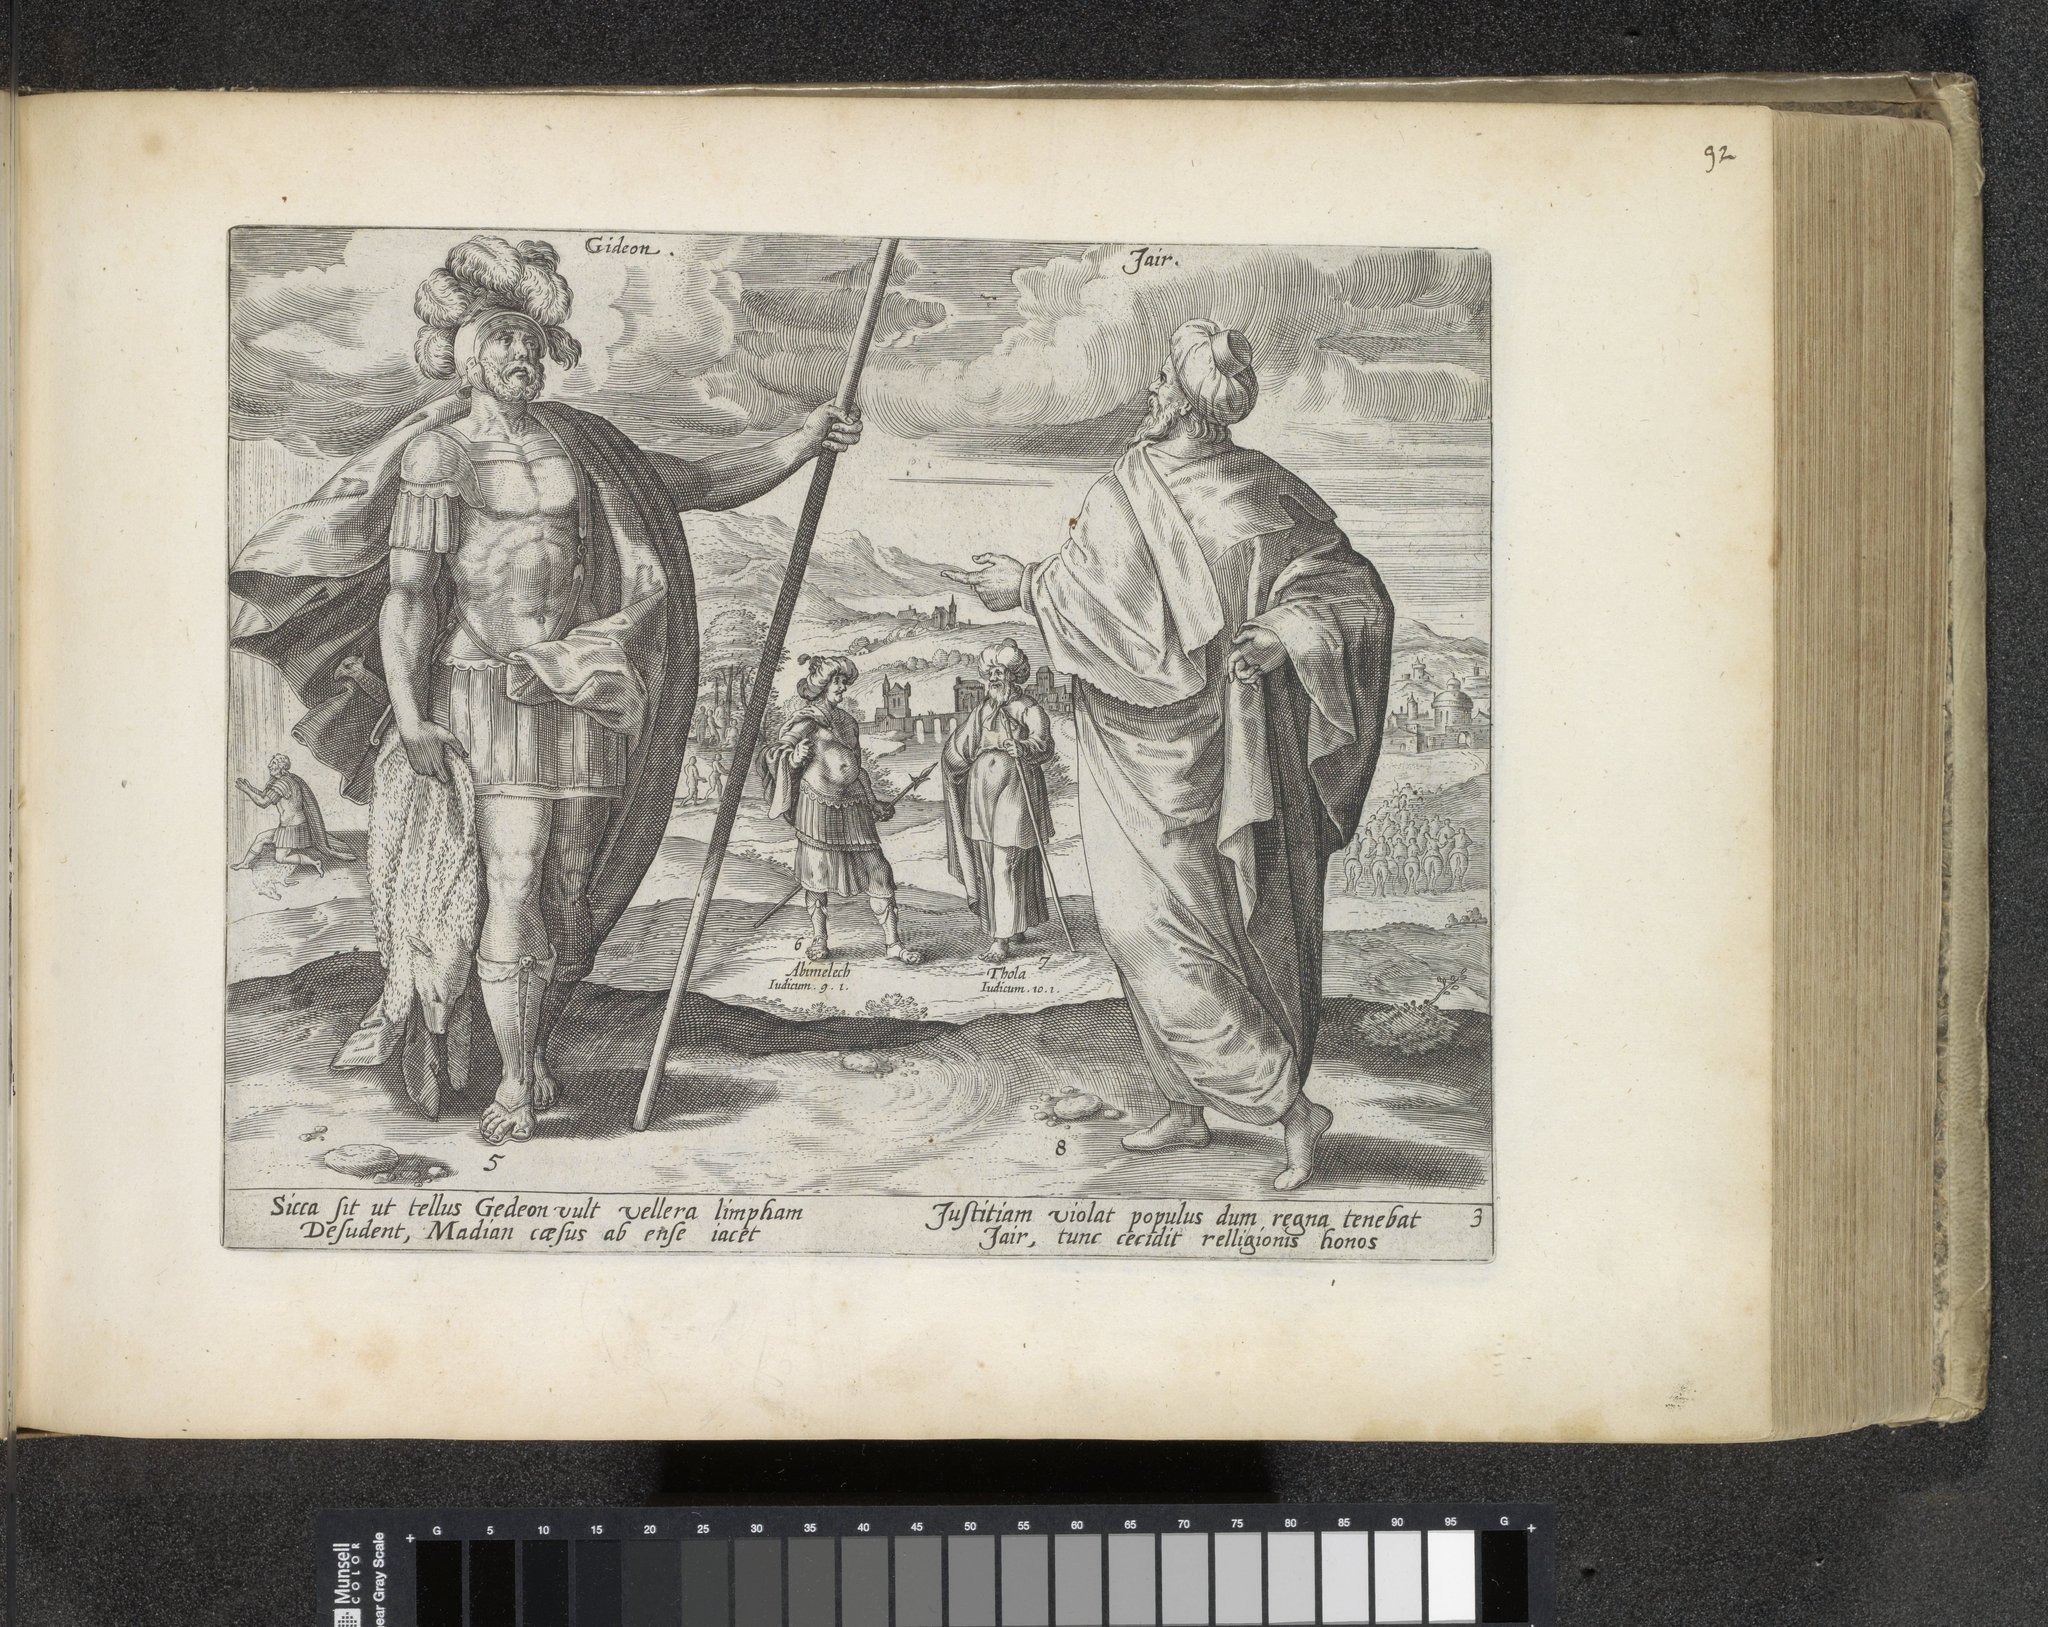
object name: album leaf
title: Gideon en Jaïr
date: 1579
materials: paper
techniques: engraving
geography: amsterdam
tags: those who lap water by putting their hand to their mouth are separated from those who kneel down to drink the water ~ selection of gideon's men, the dew is on the fleece only, the ground is dry (first sign given to gideon)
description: De rechters Gideon en Jaïr. Gideon houdt de schapenvacht in de hand. Op de achtergrond bidt Gideon bij de schapenvacht en valt er dauw op de schapenvacht. In het landschap knielen de manschappen van Gideon bij een rivier om te drinken. Jaïr wijst naar het landschap. Zijn dertig zonen berijden ieder een ezelshengst. In het midden staan Abimelech en Tola. Onder de voorstelling toelichtende teksten in het Latijn. Deze prent maakt deel uit van een album.